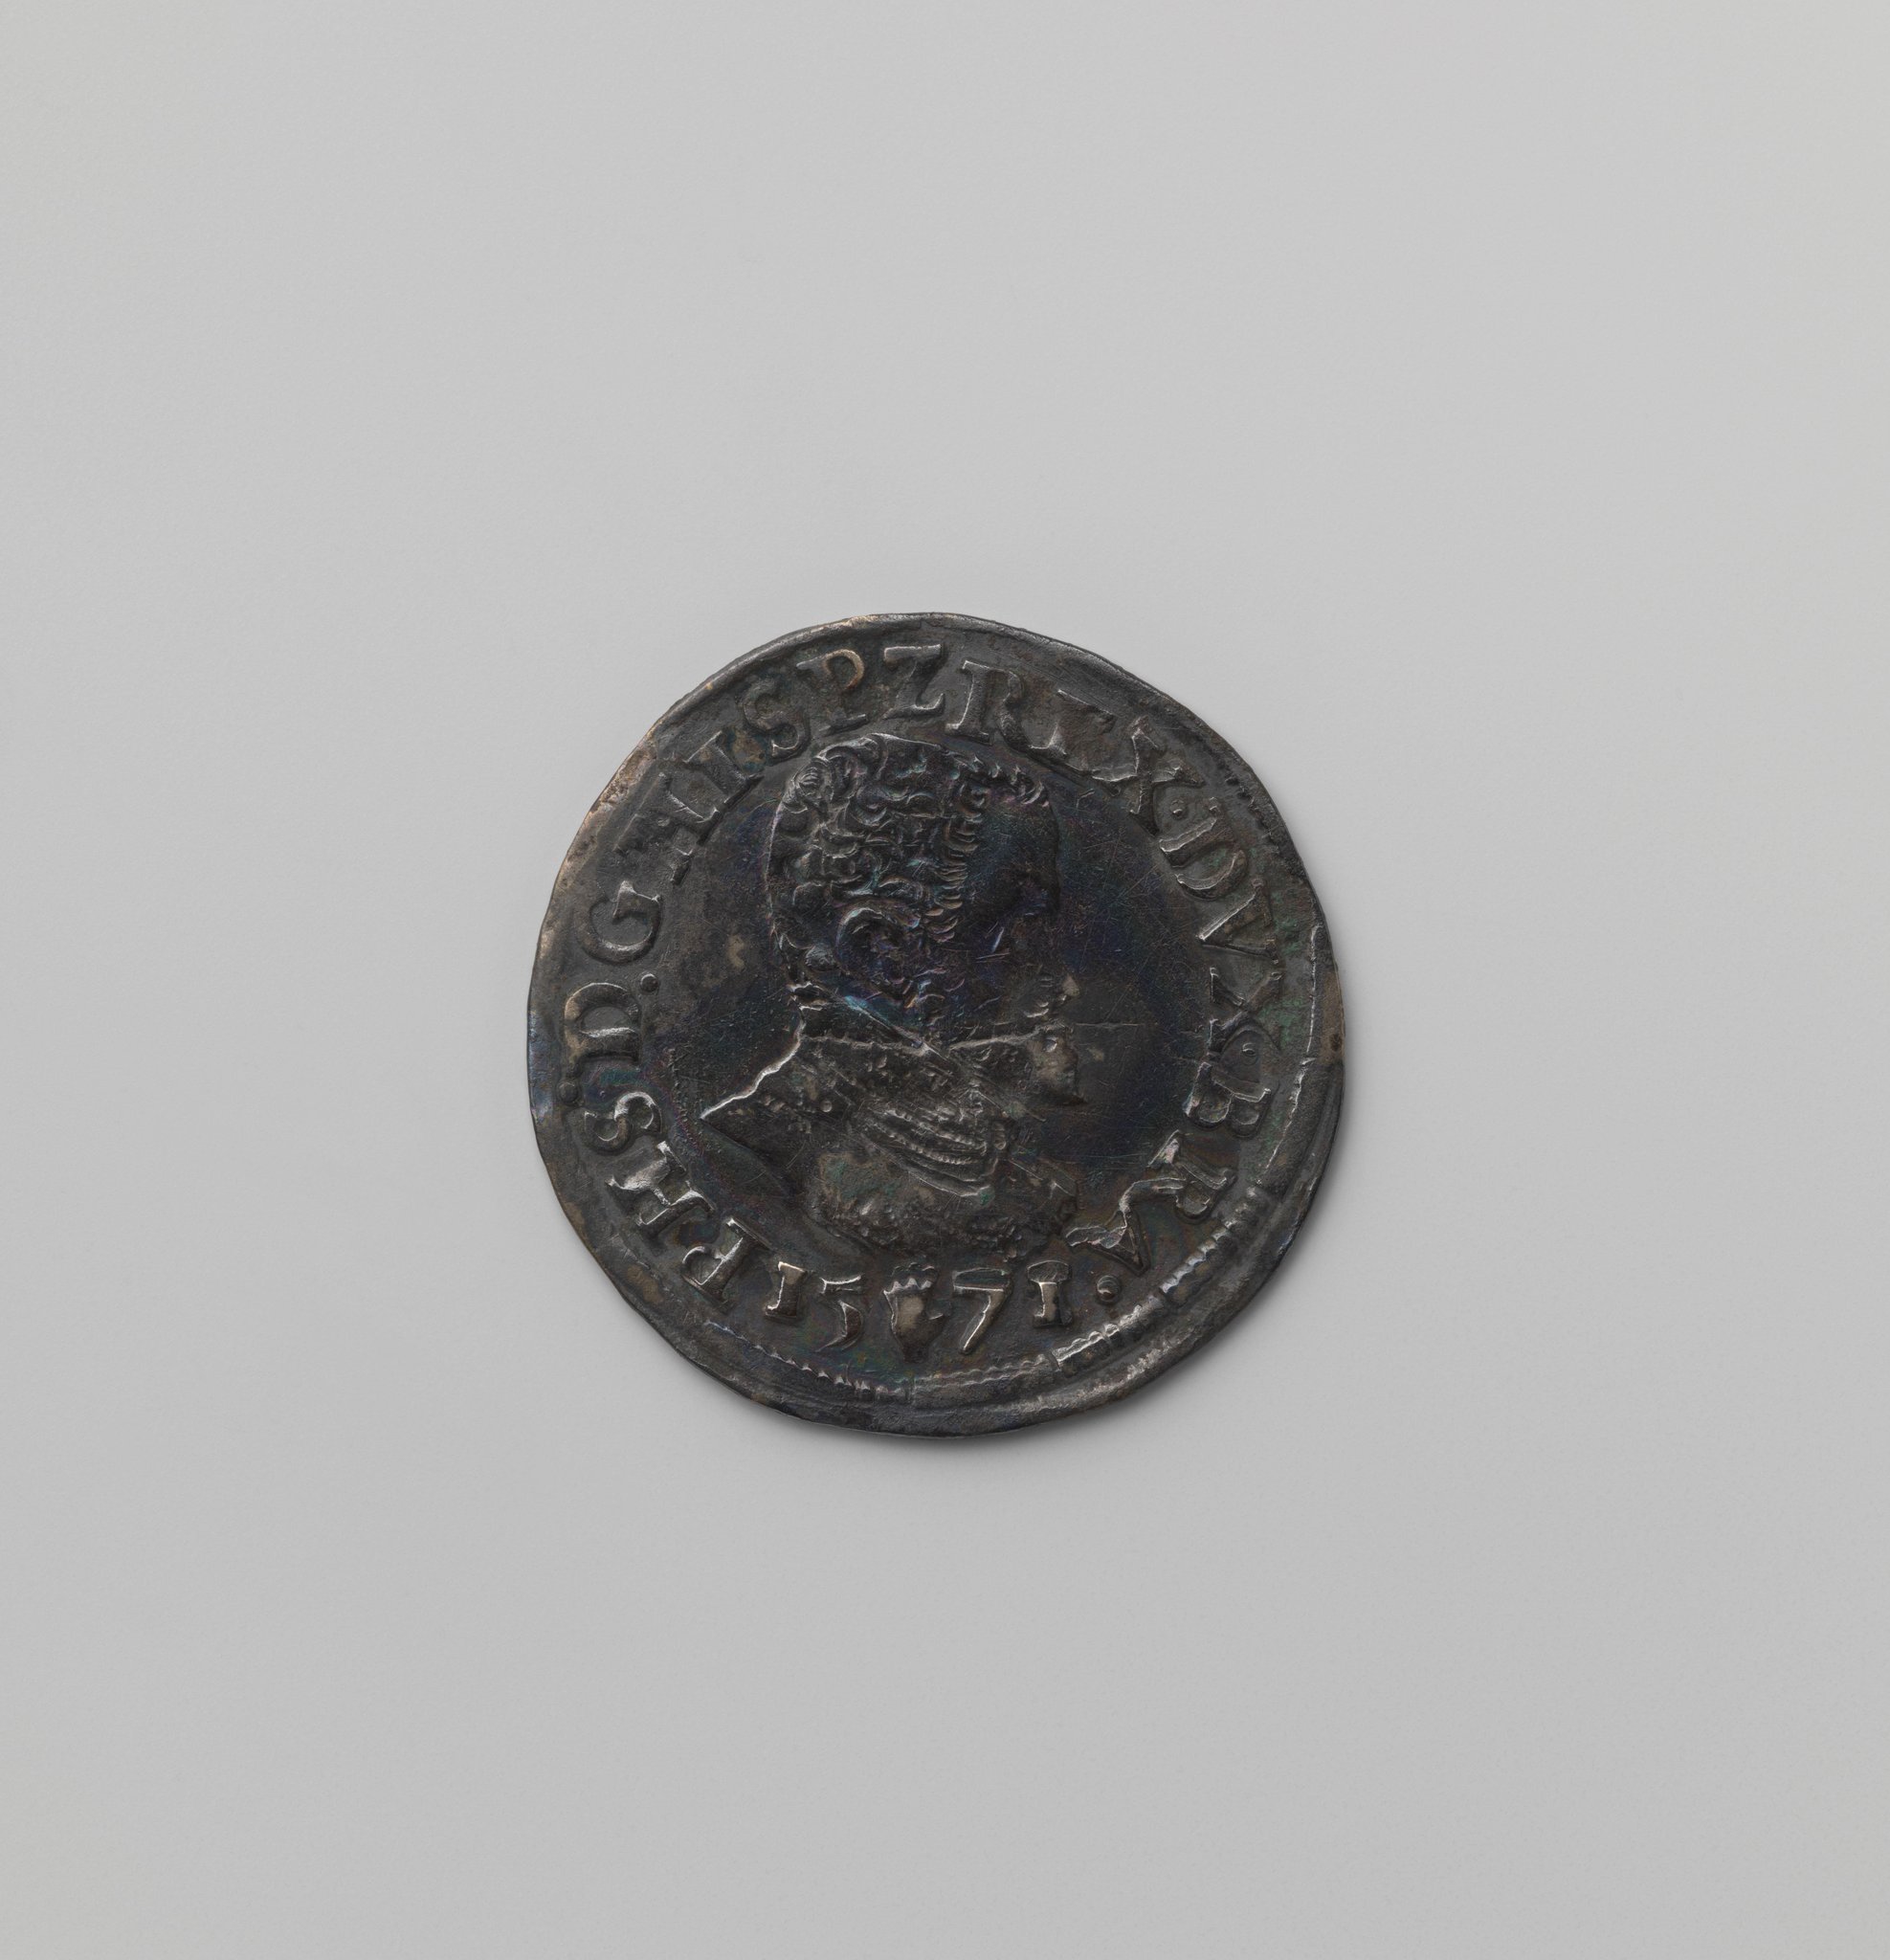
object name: coin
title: Brabant, Philips II, tiende philipsdaalder, 1571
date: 1571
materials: silver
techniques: striking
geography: antwerp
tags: philip ii of spain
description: Zilveren munt. Voorzijde: hoofd van Philips II naar rechts. Jaartal, waartussen hand, in omschrift.Keerzijde: op stokkenkruis vuurijzer met vonken. Daarboven kroon, daaronder gulden vlies.